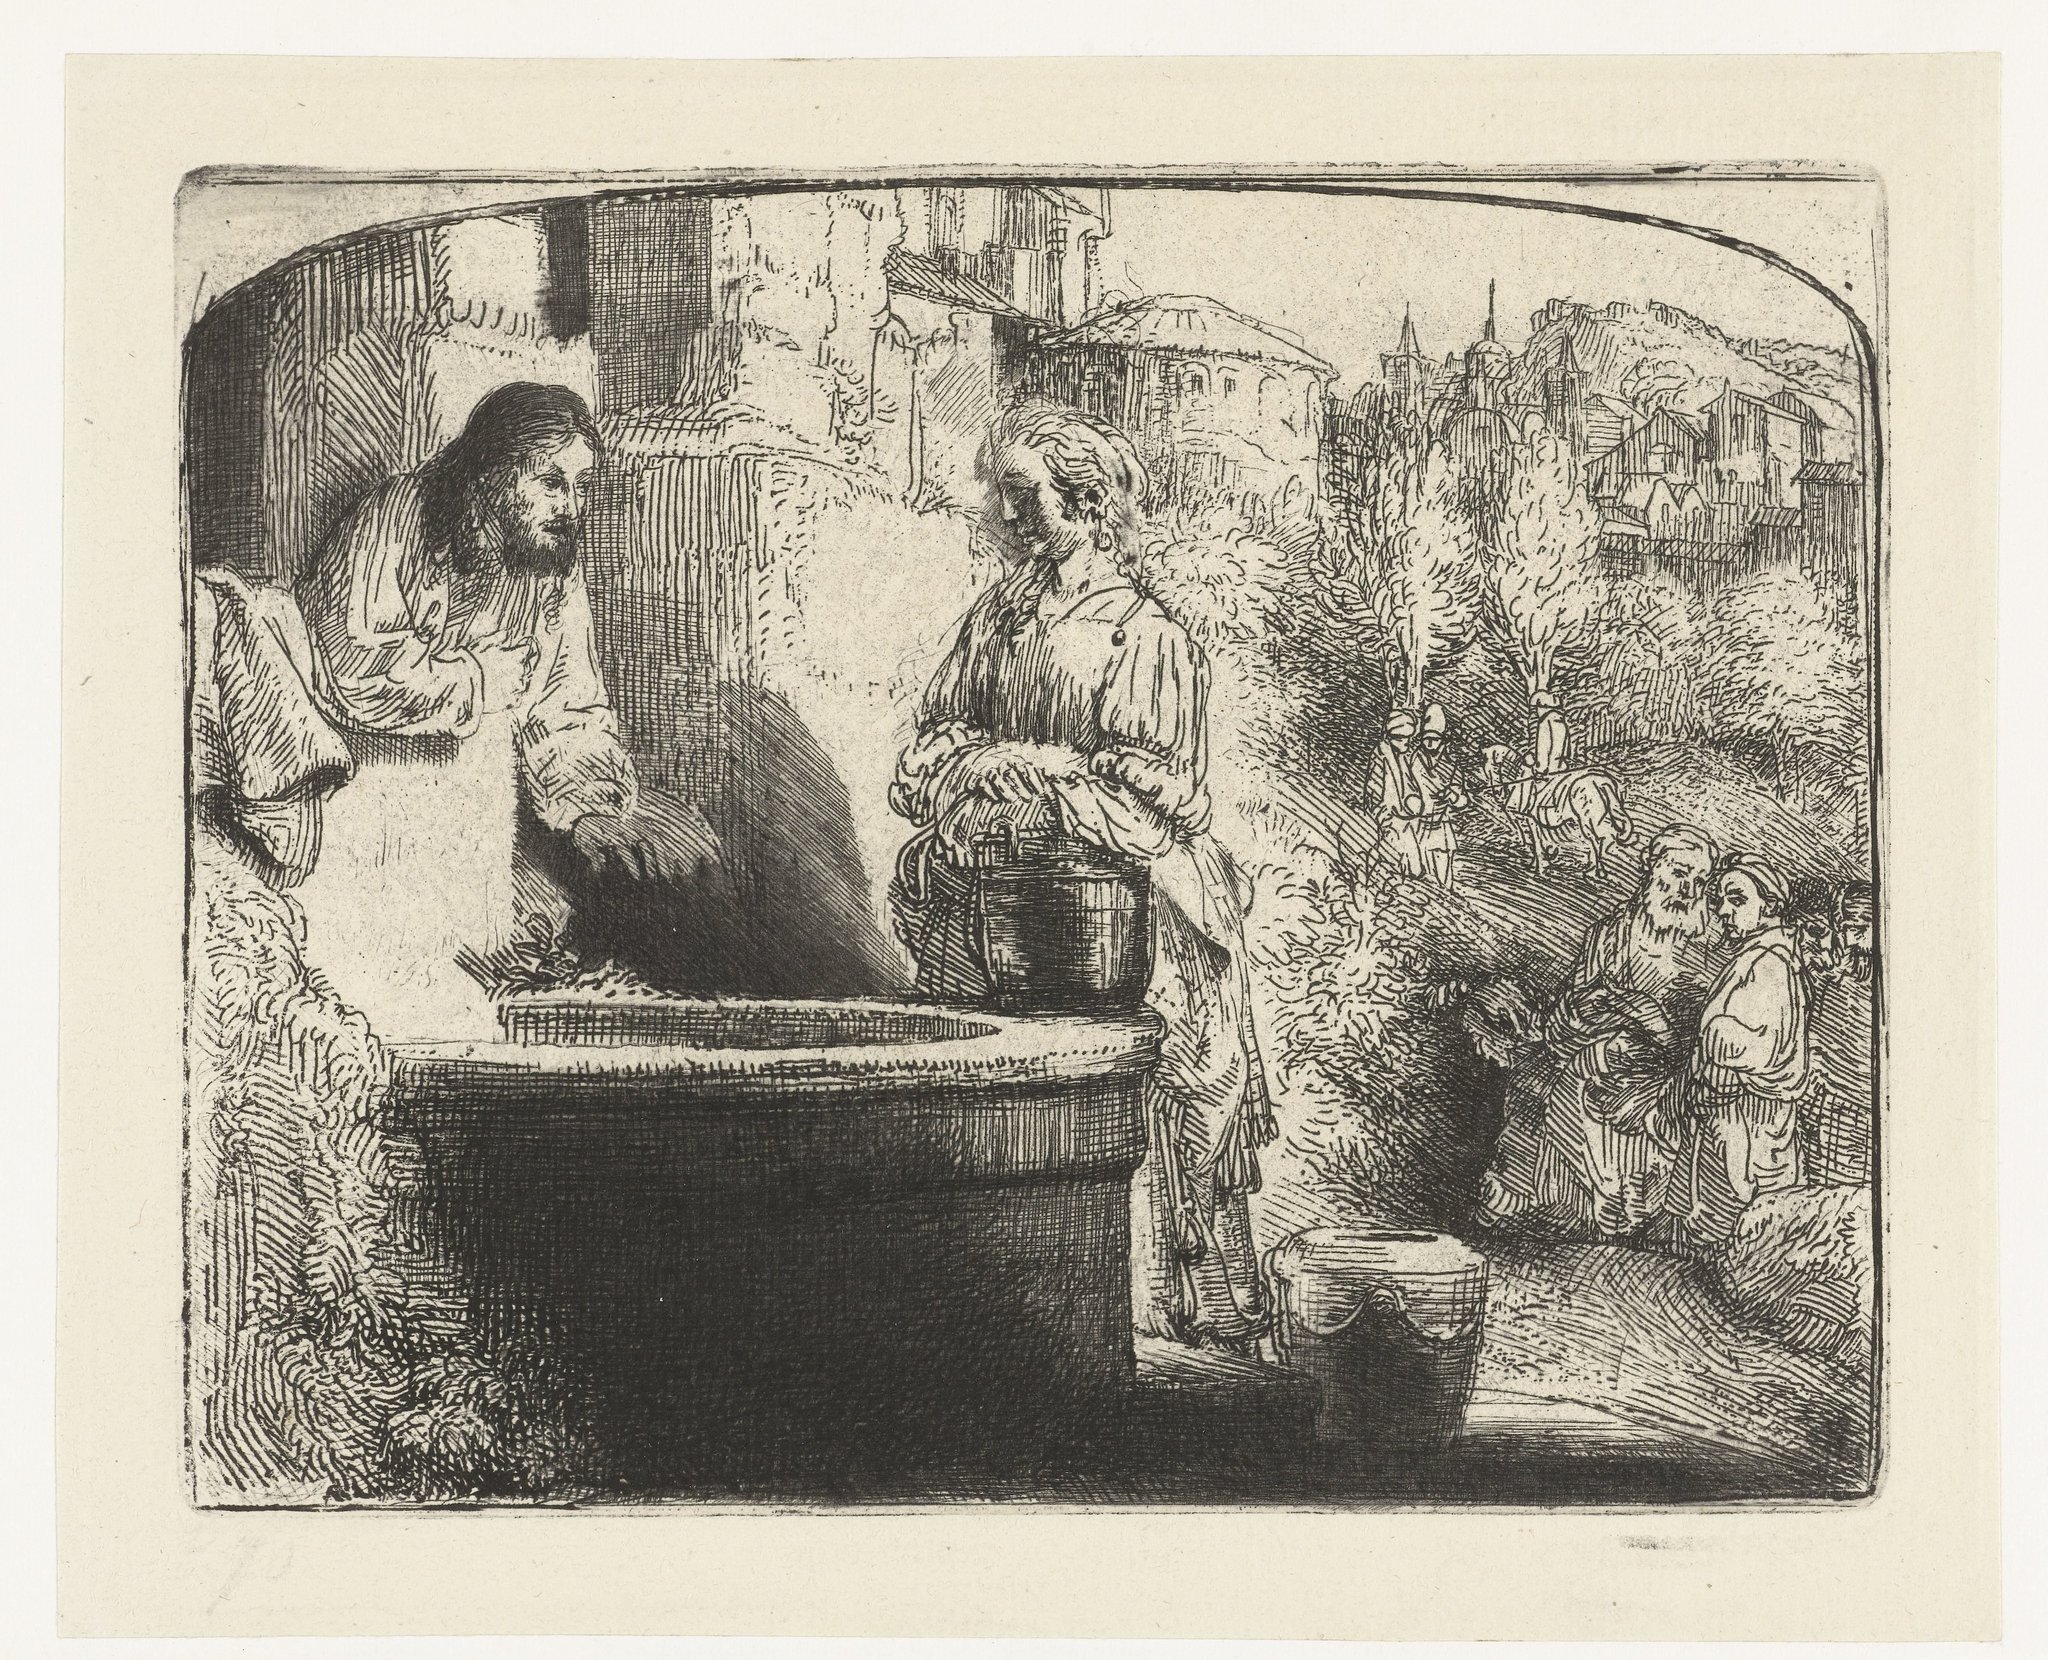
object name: print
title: Christ and the woman of Samaria: an arched print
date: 1657-1658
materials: paper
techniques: drypoint, etching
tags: christ and the woman of samaria: sitting at jacob's well he asks her for a drink from her jug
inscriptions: signature and date, inscription: ‘Coppier’, signature and date: ‘Rembrandt f. 1657’